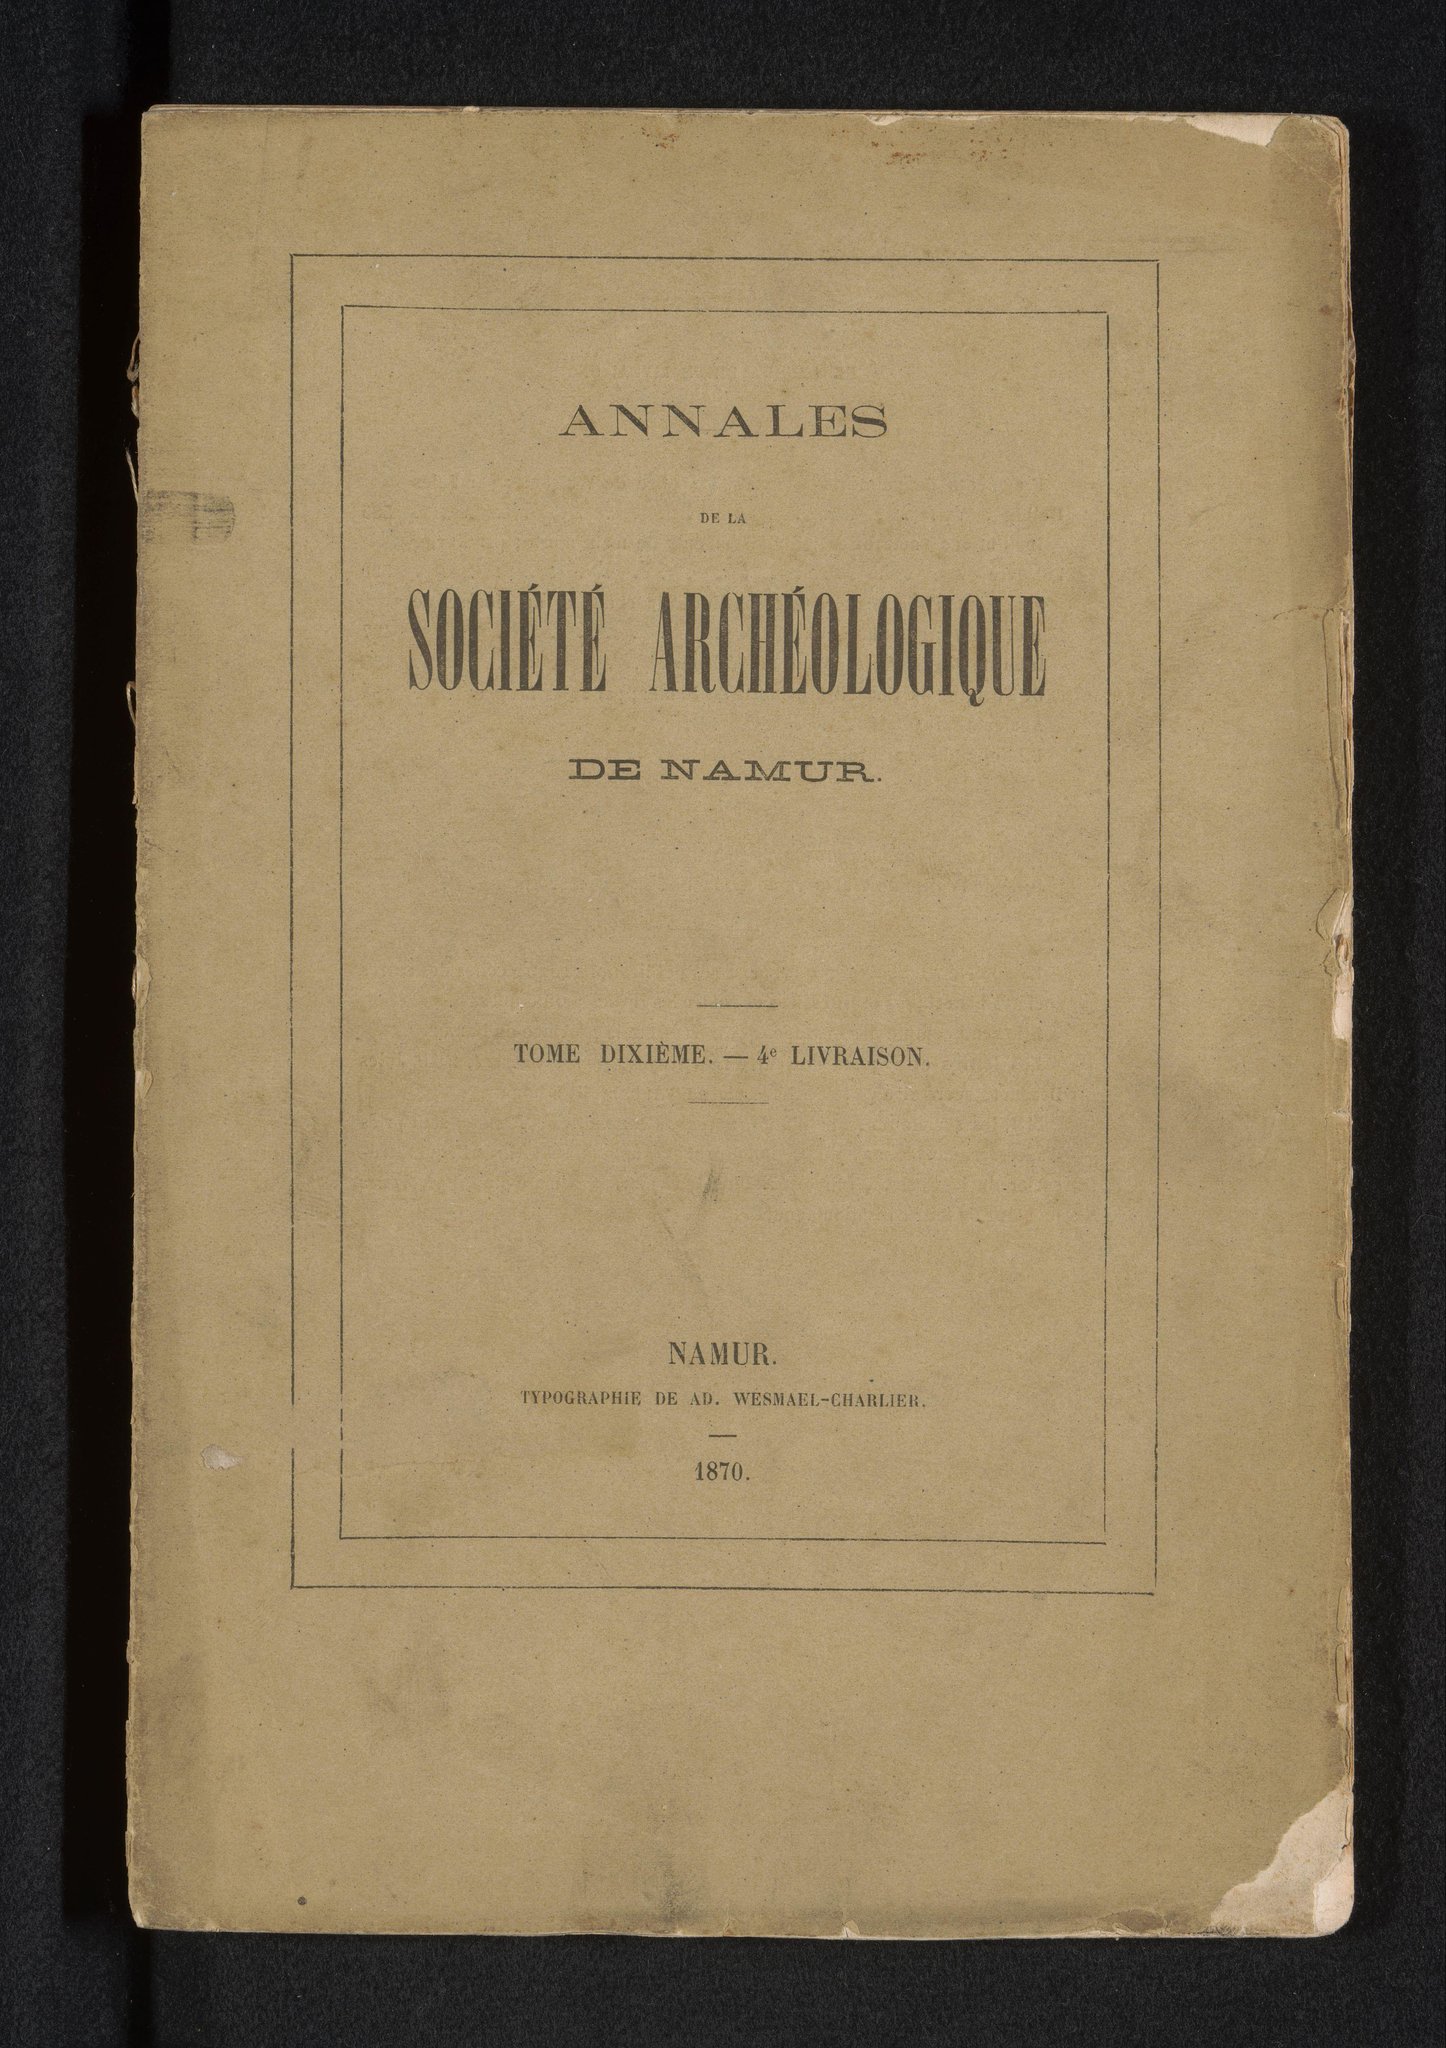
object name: book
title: Annales de la Société archéologique de Namur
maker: adolphe wesmael-charlier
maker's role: printer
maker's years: 1842-1906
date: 1870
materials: paper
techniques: photolithography, printing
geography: namur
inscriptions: annotation: ‘[...] 500,-/ Walcourt’, annotation: ‘OCT/ 1990’